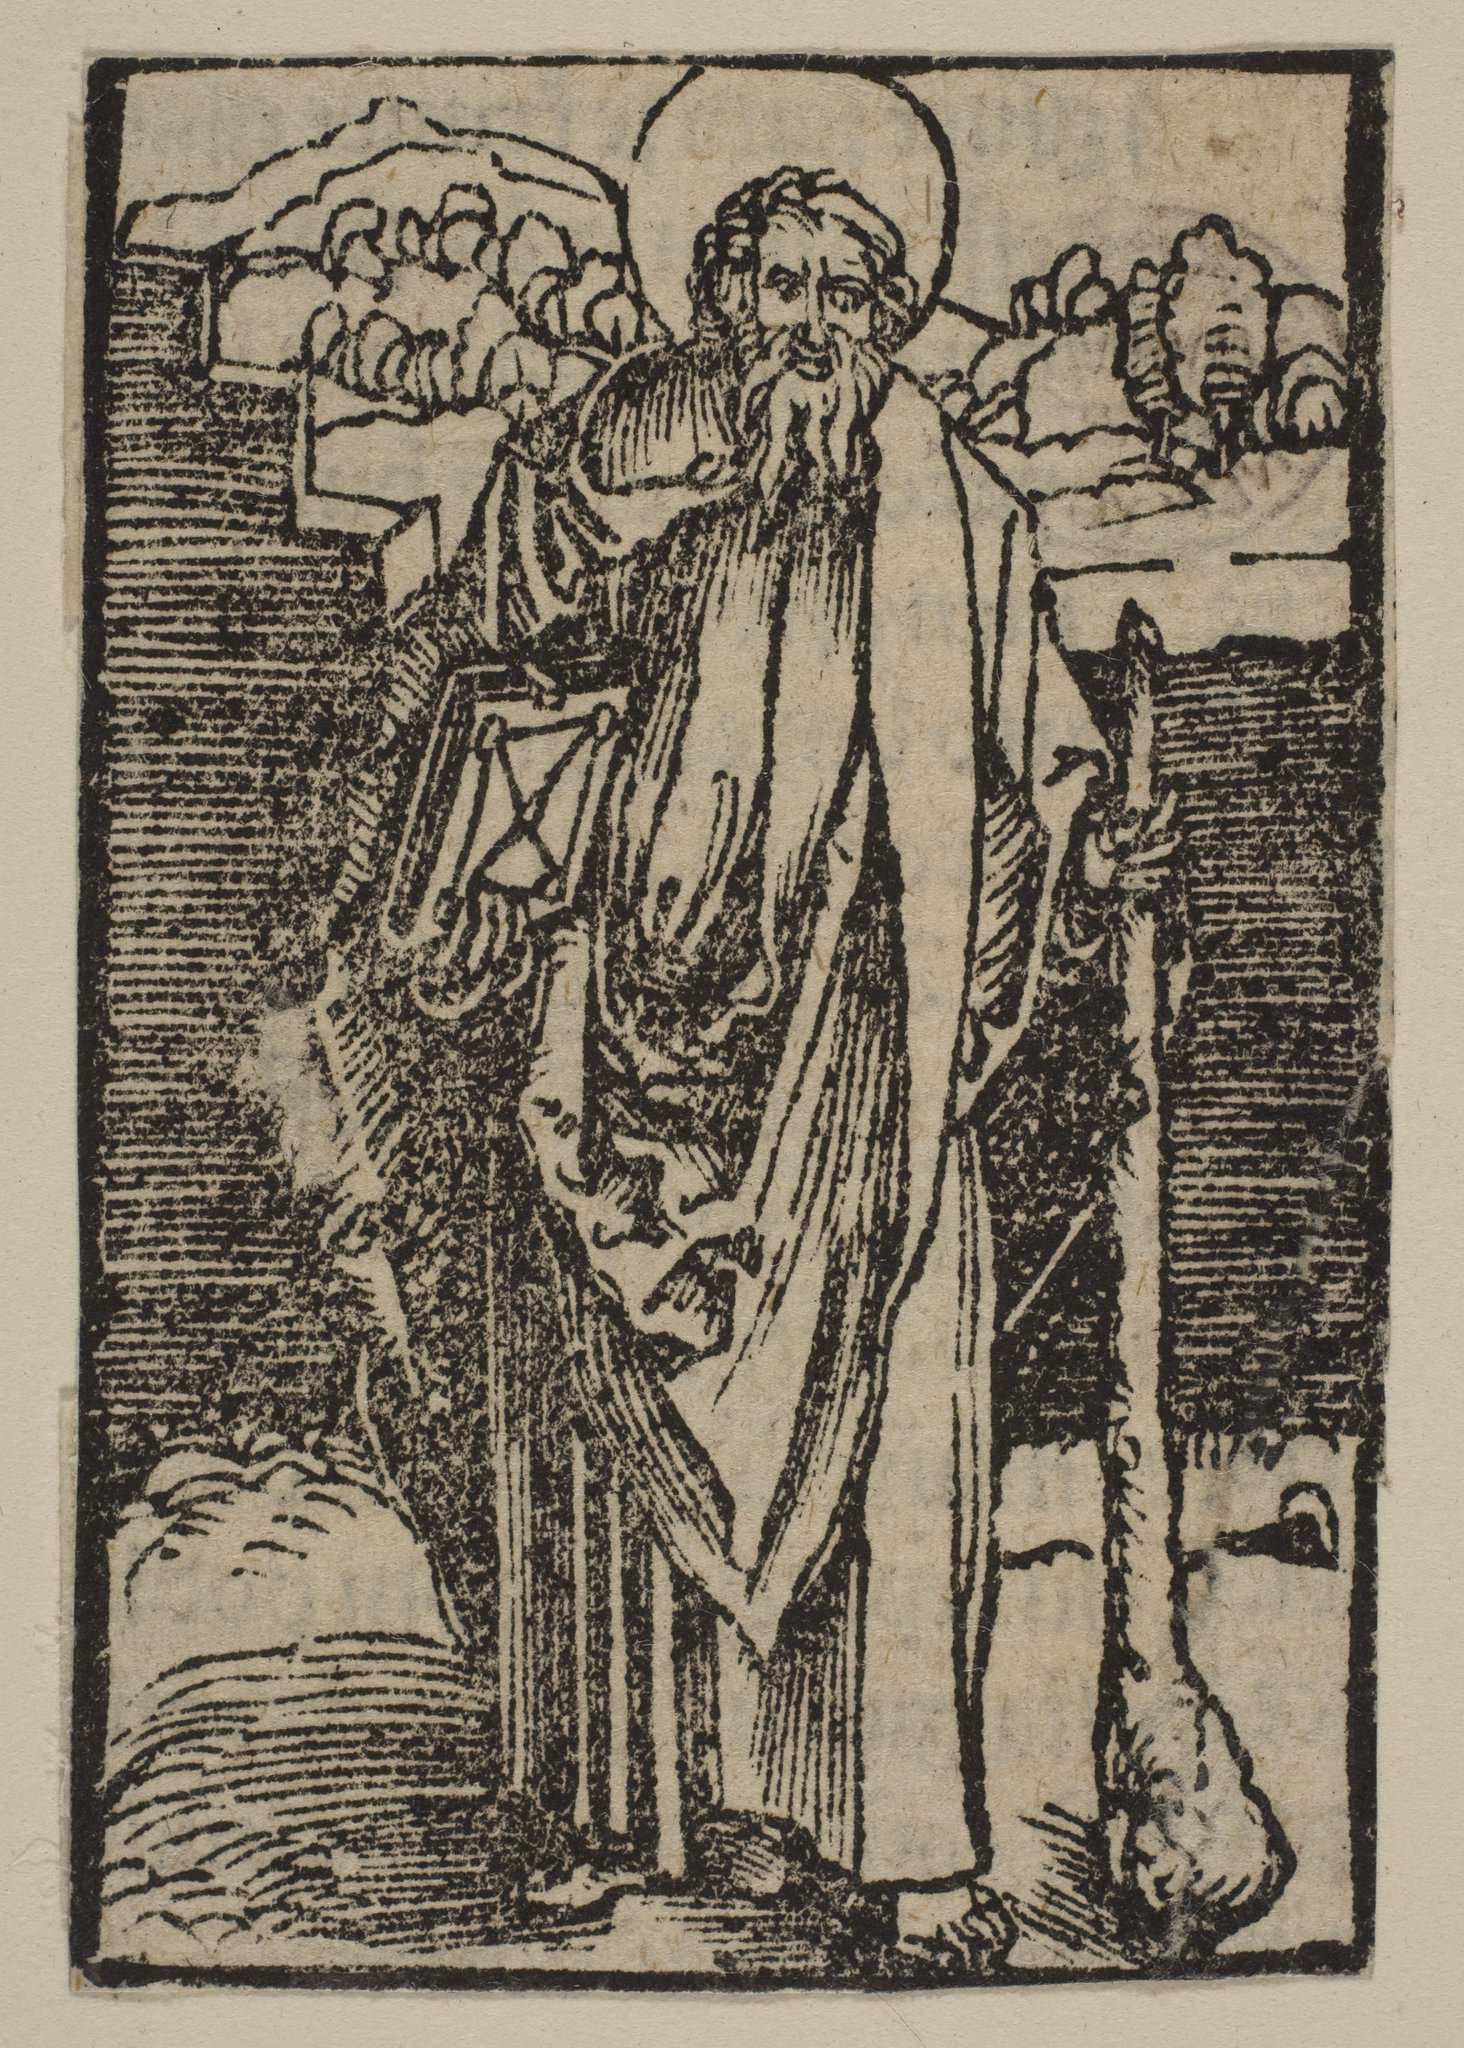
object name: print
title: Saint Judas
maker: albrecht dürer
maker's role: artist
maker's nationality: german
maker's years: 1471-1528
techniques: woodcut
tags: men,judas,saints